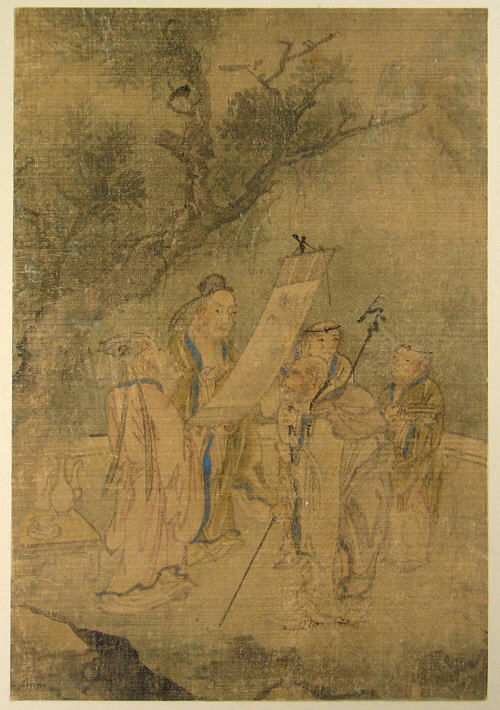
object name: album leaf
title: Examining the Hanging Picture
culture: korean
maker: unidentified artist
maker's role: artist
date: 1650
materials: ink, silk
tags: painting,men